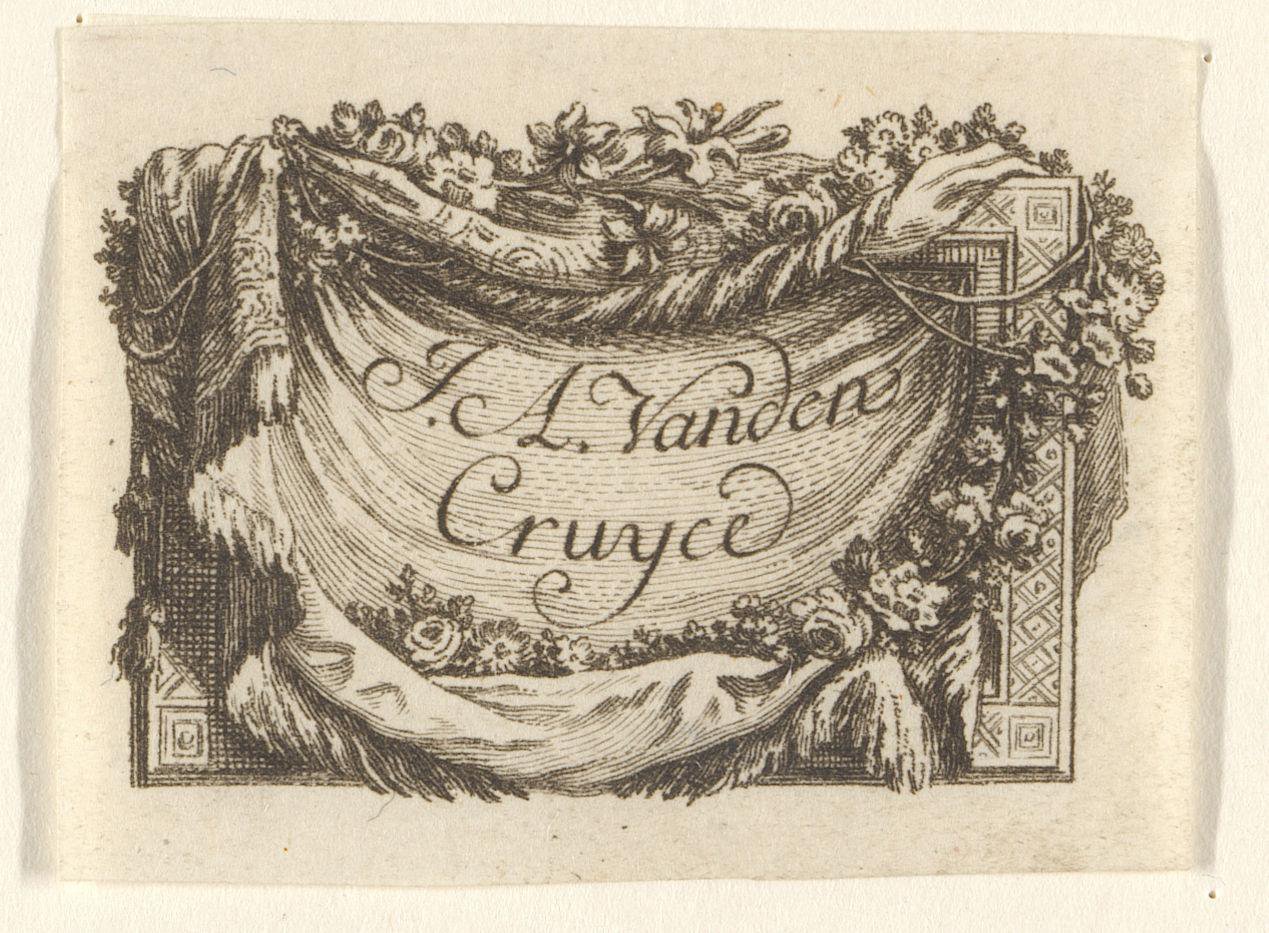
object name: print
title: Vignet met draperie en guirlandes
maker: Anonymous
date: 1650-1750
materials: paper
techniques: etching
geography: netherlands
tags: illustration ~ printed matter, book, hangings and drapery, ornament ~ festoon, garland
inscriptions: collector's mark: Lugt 2228